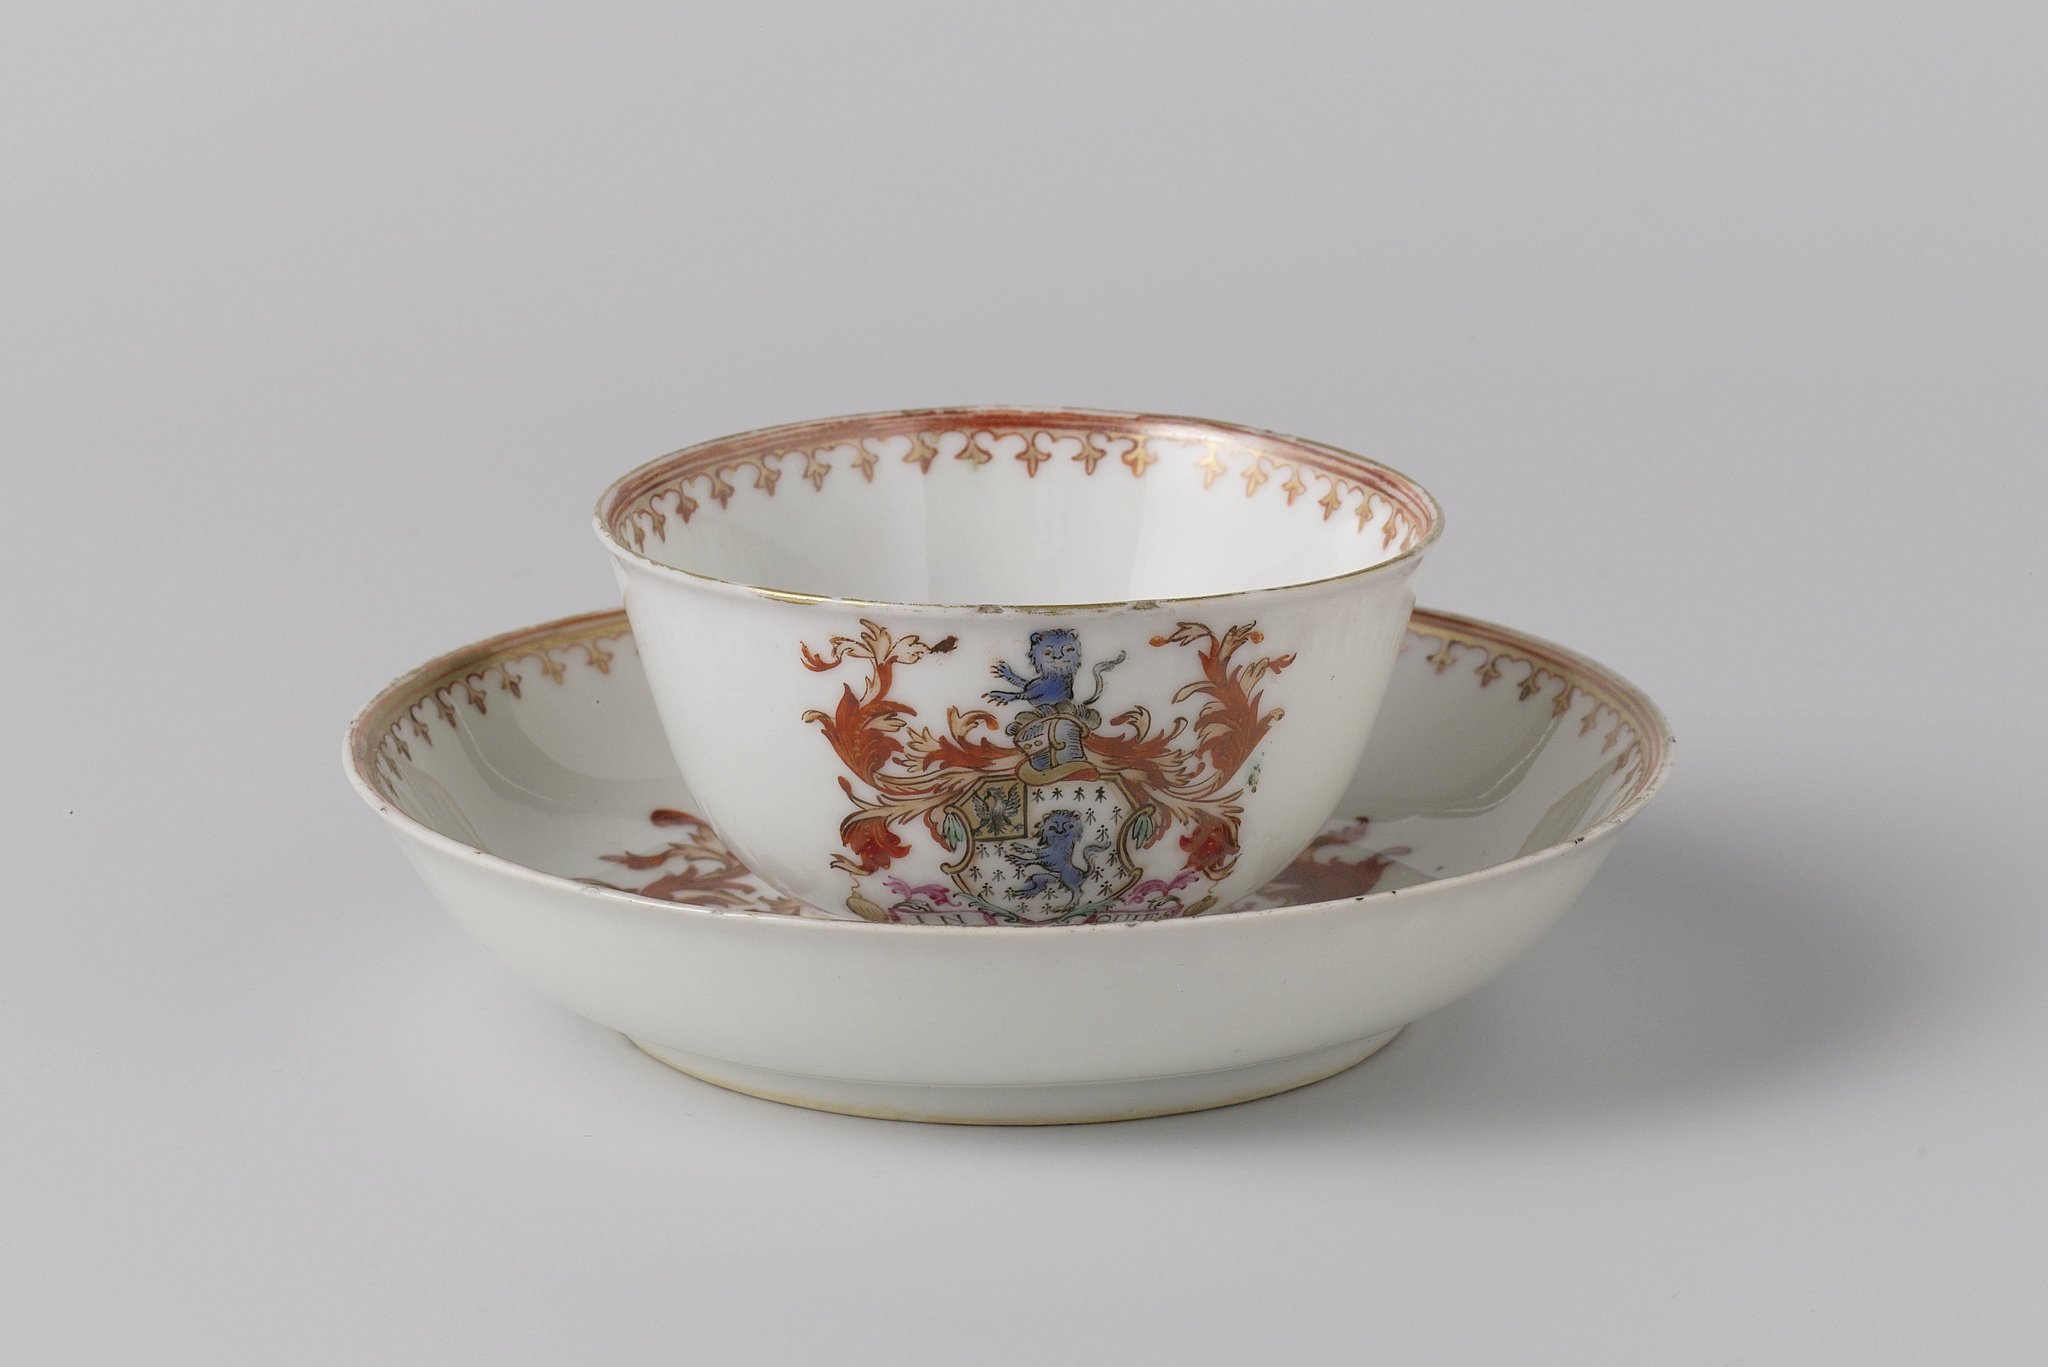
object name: kop en schotel, kop en schotel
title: Bell-shaped cup and saucer with the arms of the Edwards family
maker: Anonymous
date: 1740-1760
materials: glaze, gold, paint, porcelain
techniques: firing, gilding, turning, vitrification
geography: china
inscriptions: inscription: ‘IN CAELO QUIES’, label: ‘Edwards of Iyrington, Norfolk’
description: Klokvormige kop en schotel van porselein, beschilderd op het glazuur in blauw, rood, roze, groen, zwart en goud. Op het plat het wapen van de familie Edwards met een blauwe leeuw op een witte achtergrond met zwarte tekens; in de linker hoek een vak met een adelaar. Het helmteken is ook een blauwe leeuw, omgeven door acanthusbladeren. Onder het wapen een banderol met het opschrift 'IN CAELO QUIES', 'de rust komt in de hemel'. Op de binnenrand een spearhead-border. De kop met dezelfde decoratie. Oud label op de onderzijde met 'Edwards of Iyrington, Norfolk'. Enkele chips in de rand van de schotel. Wapenporselein met emailkleuren.